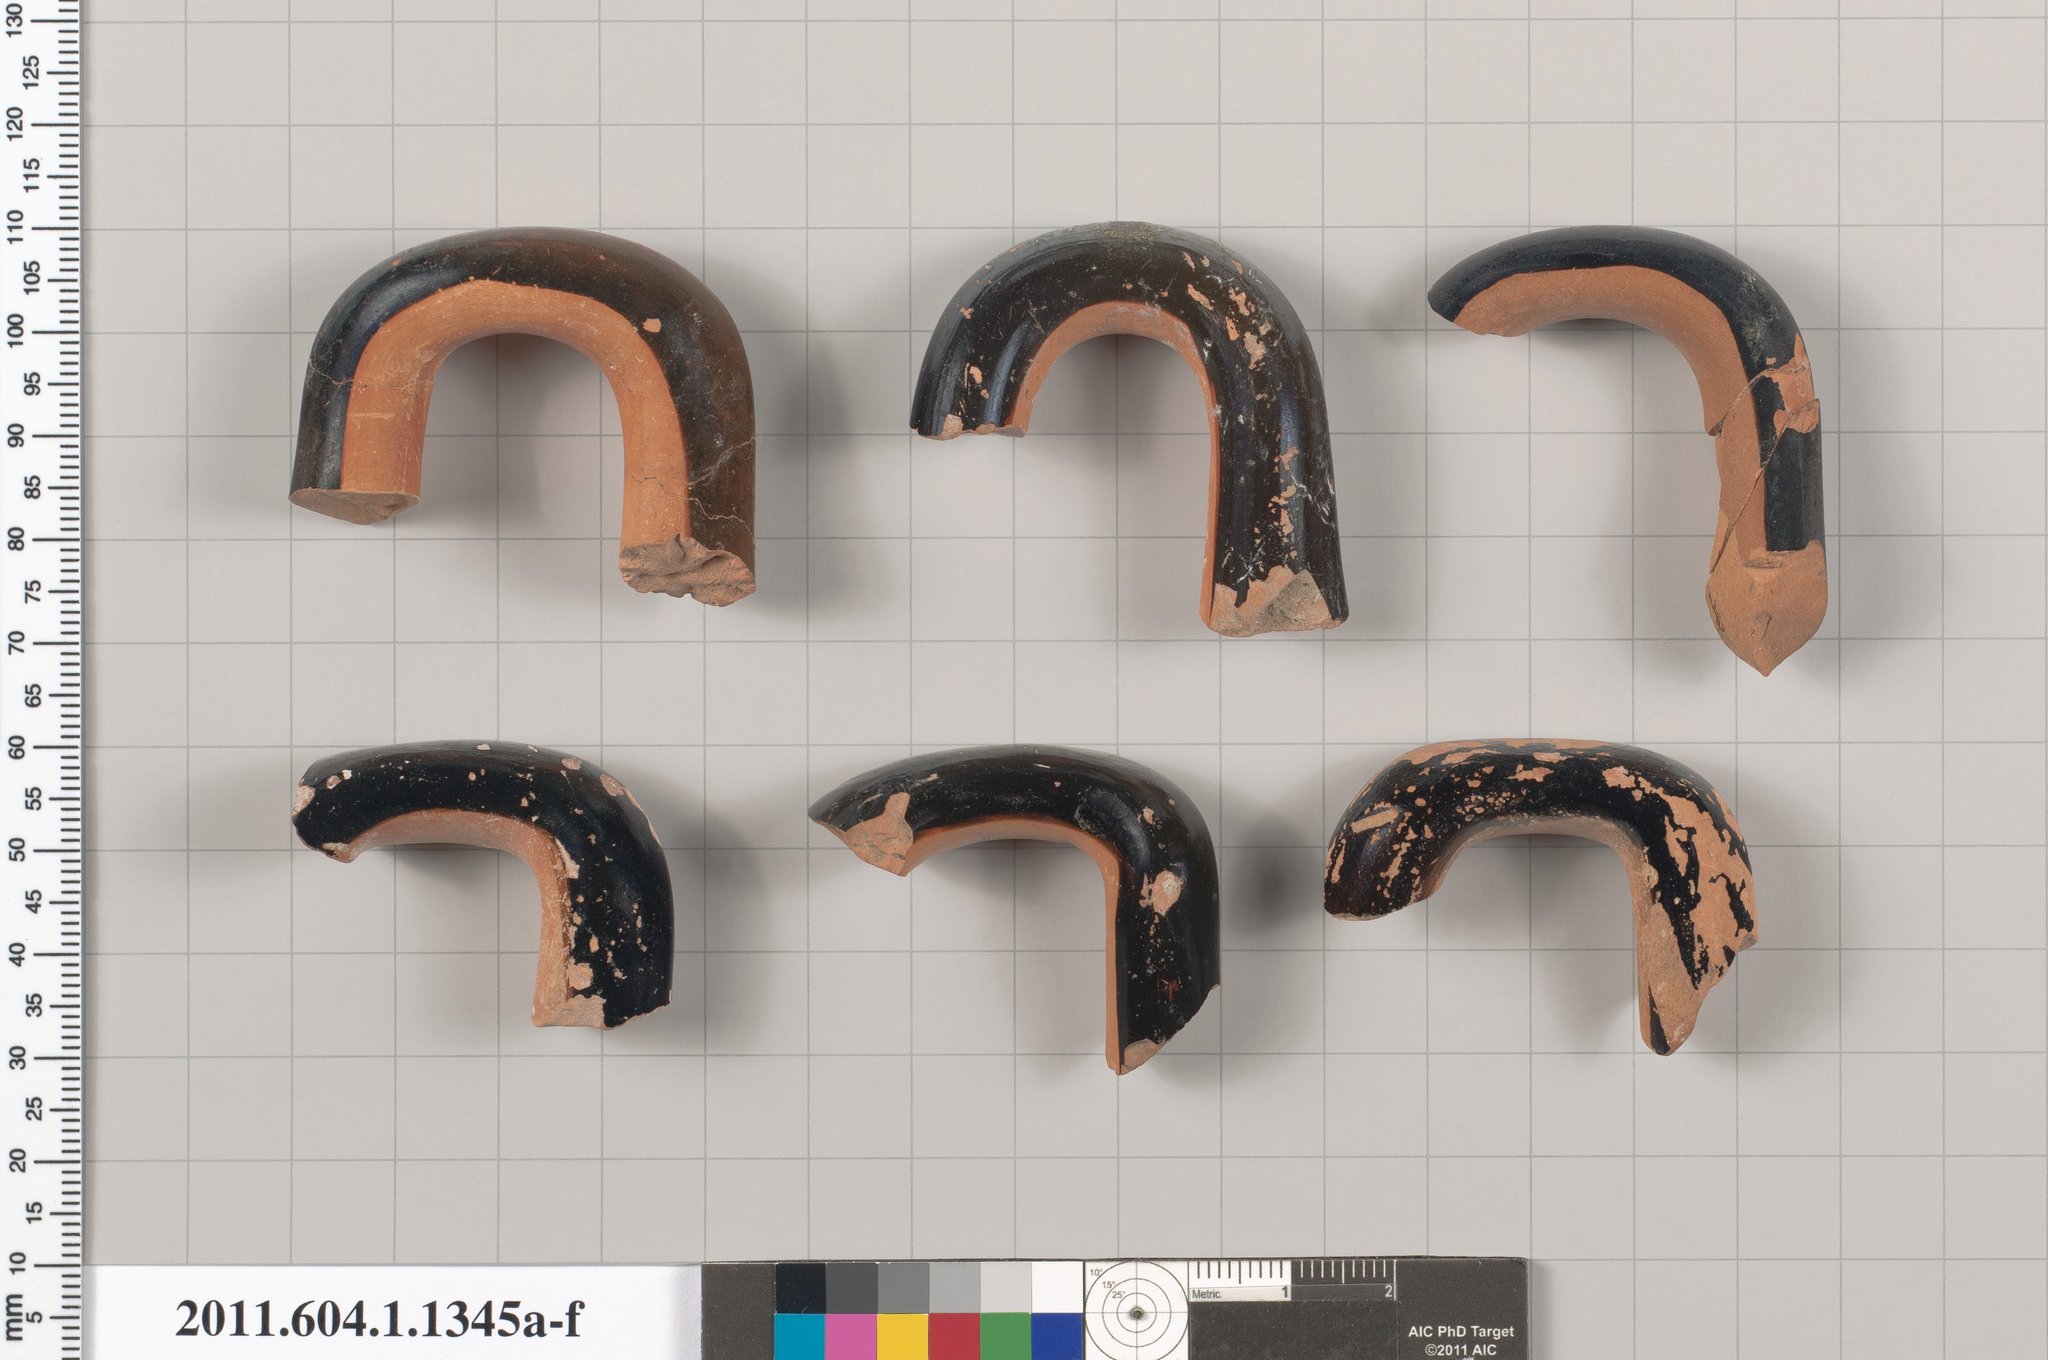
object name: kylix fragment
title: Terracotta fragments of kylikes (drinking cups)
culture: greek, attic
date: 500-401 BCE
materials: terracotta